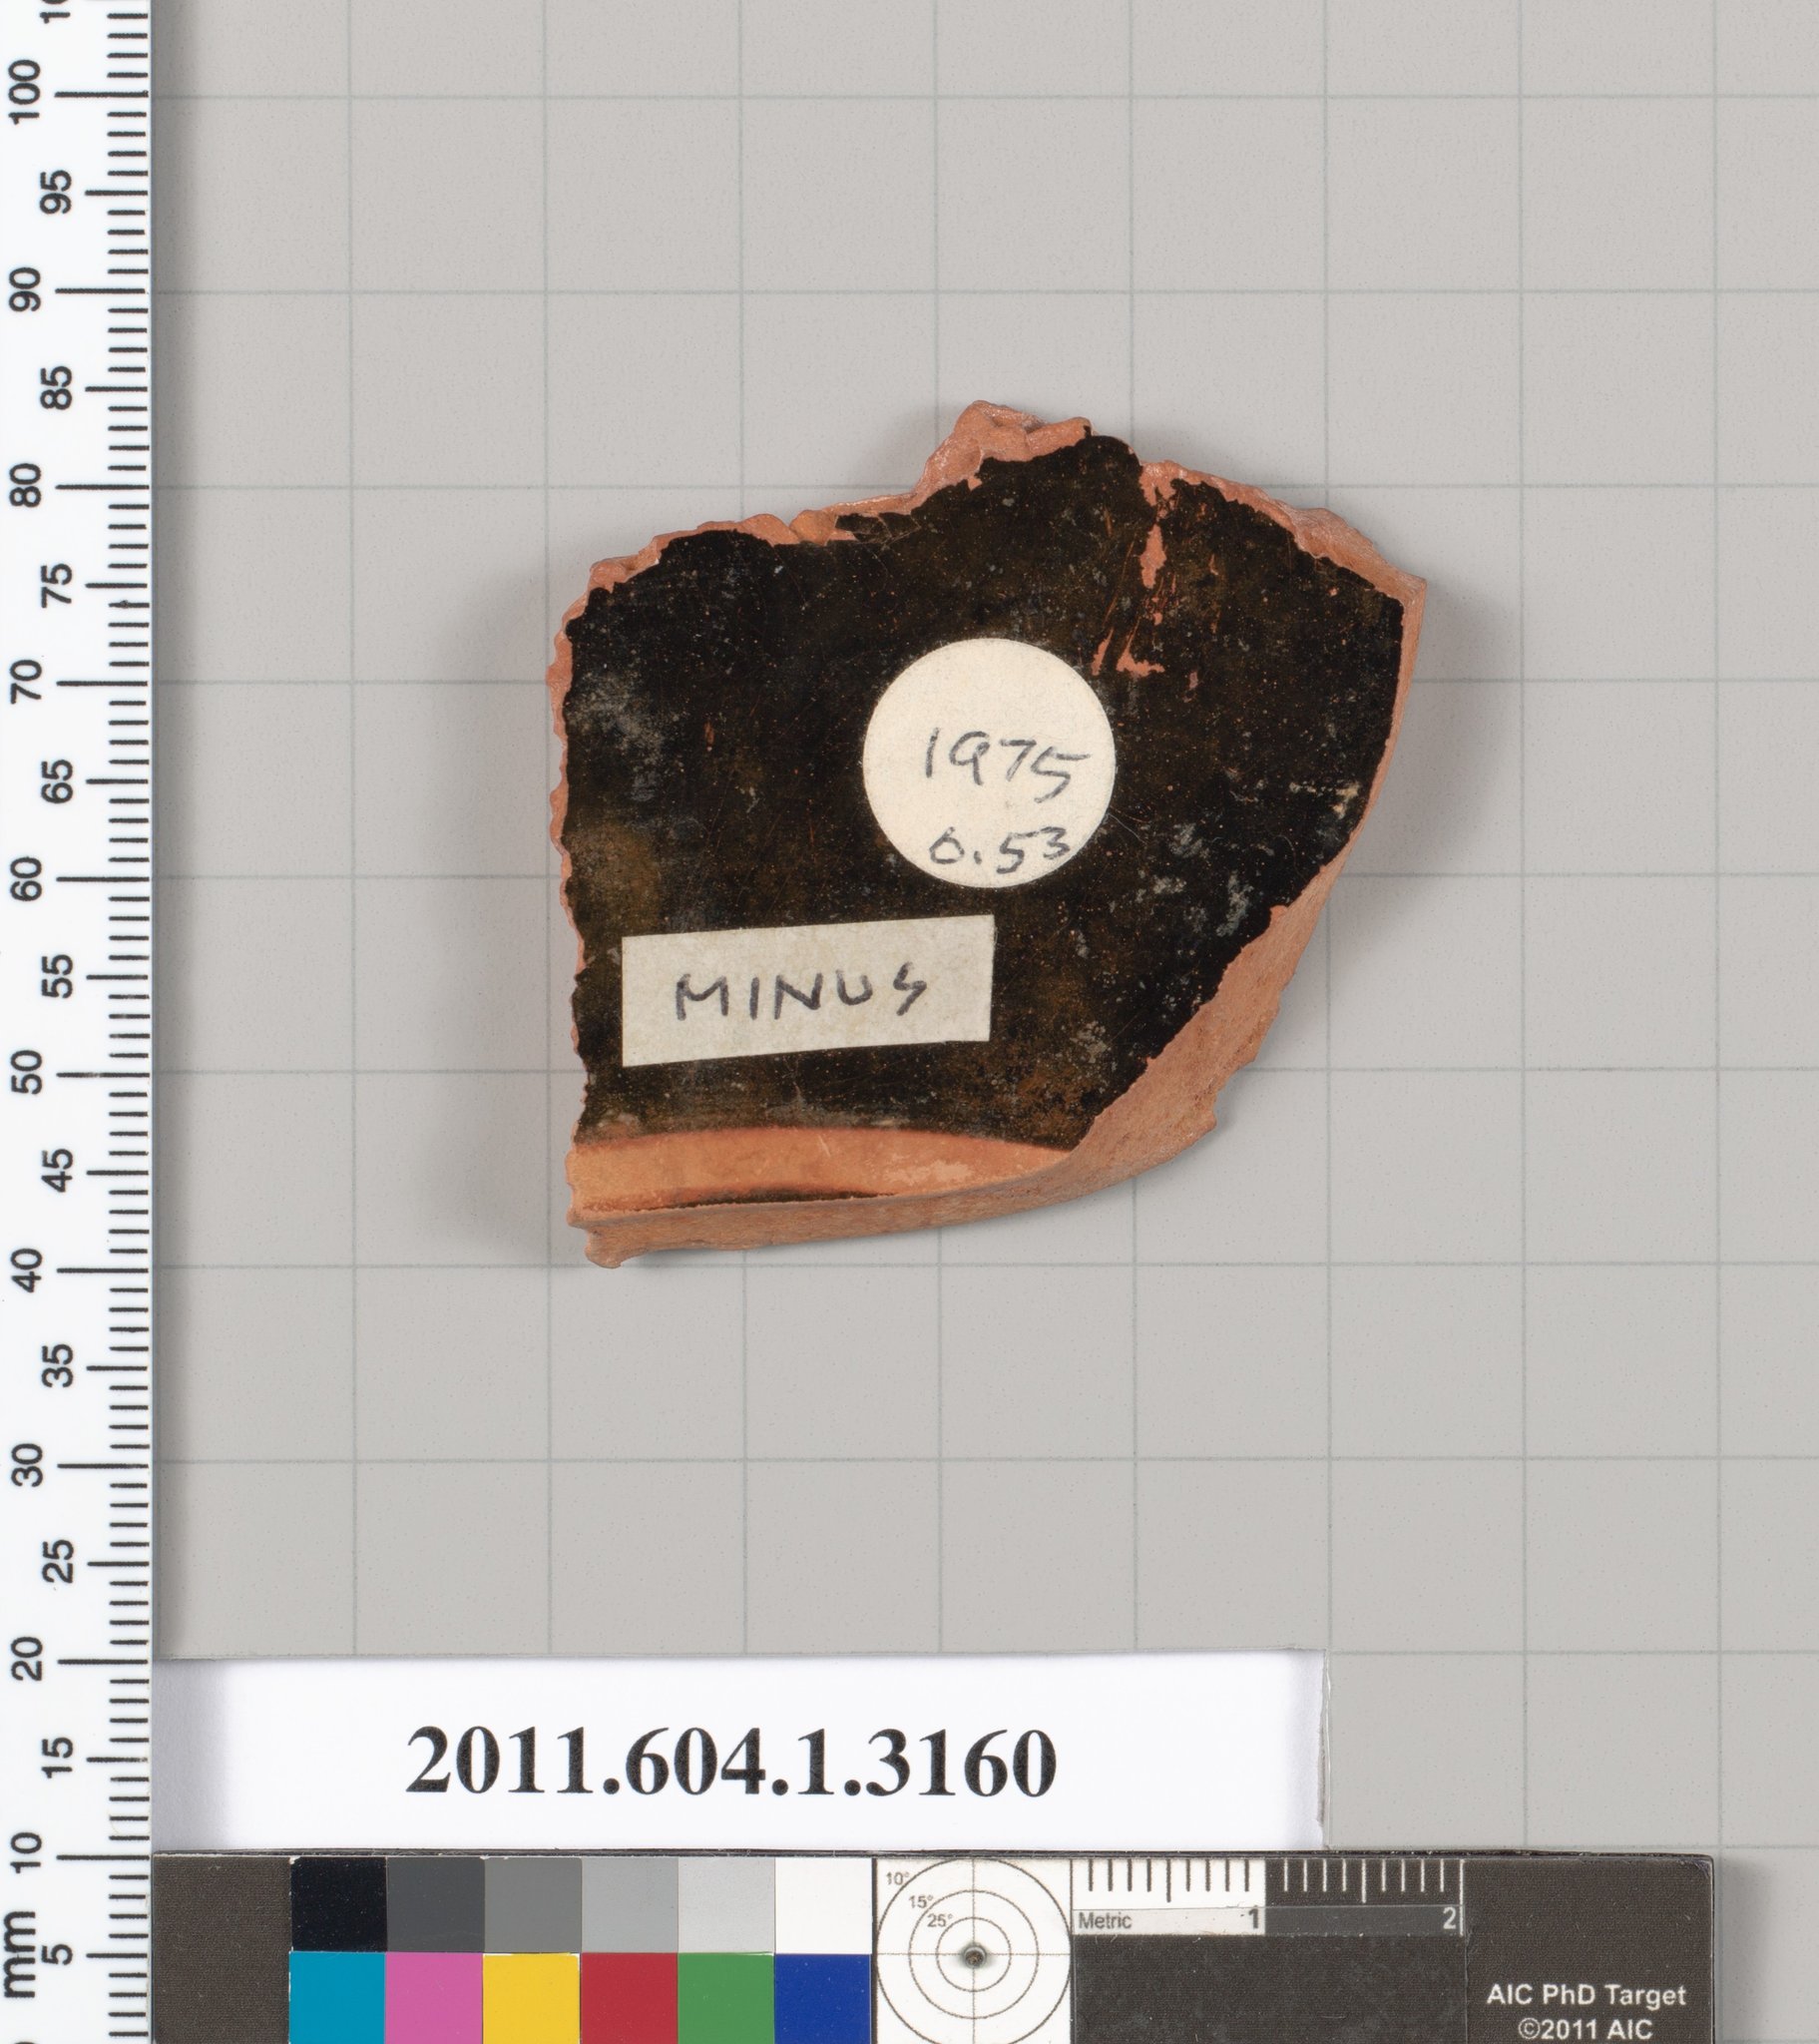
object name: kylix fragment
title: Terracotta fragment of a kylix (drinking cup)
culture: greek, attic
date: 500-476 BCE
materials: terracotta